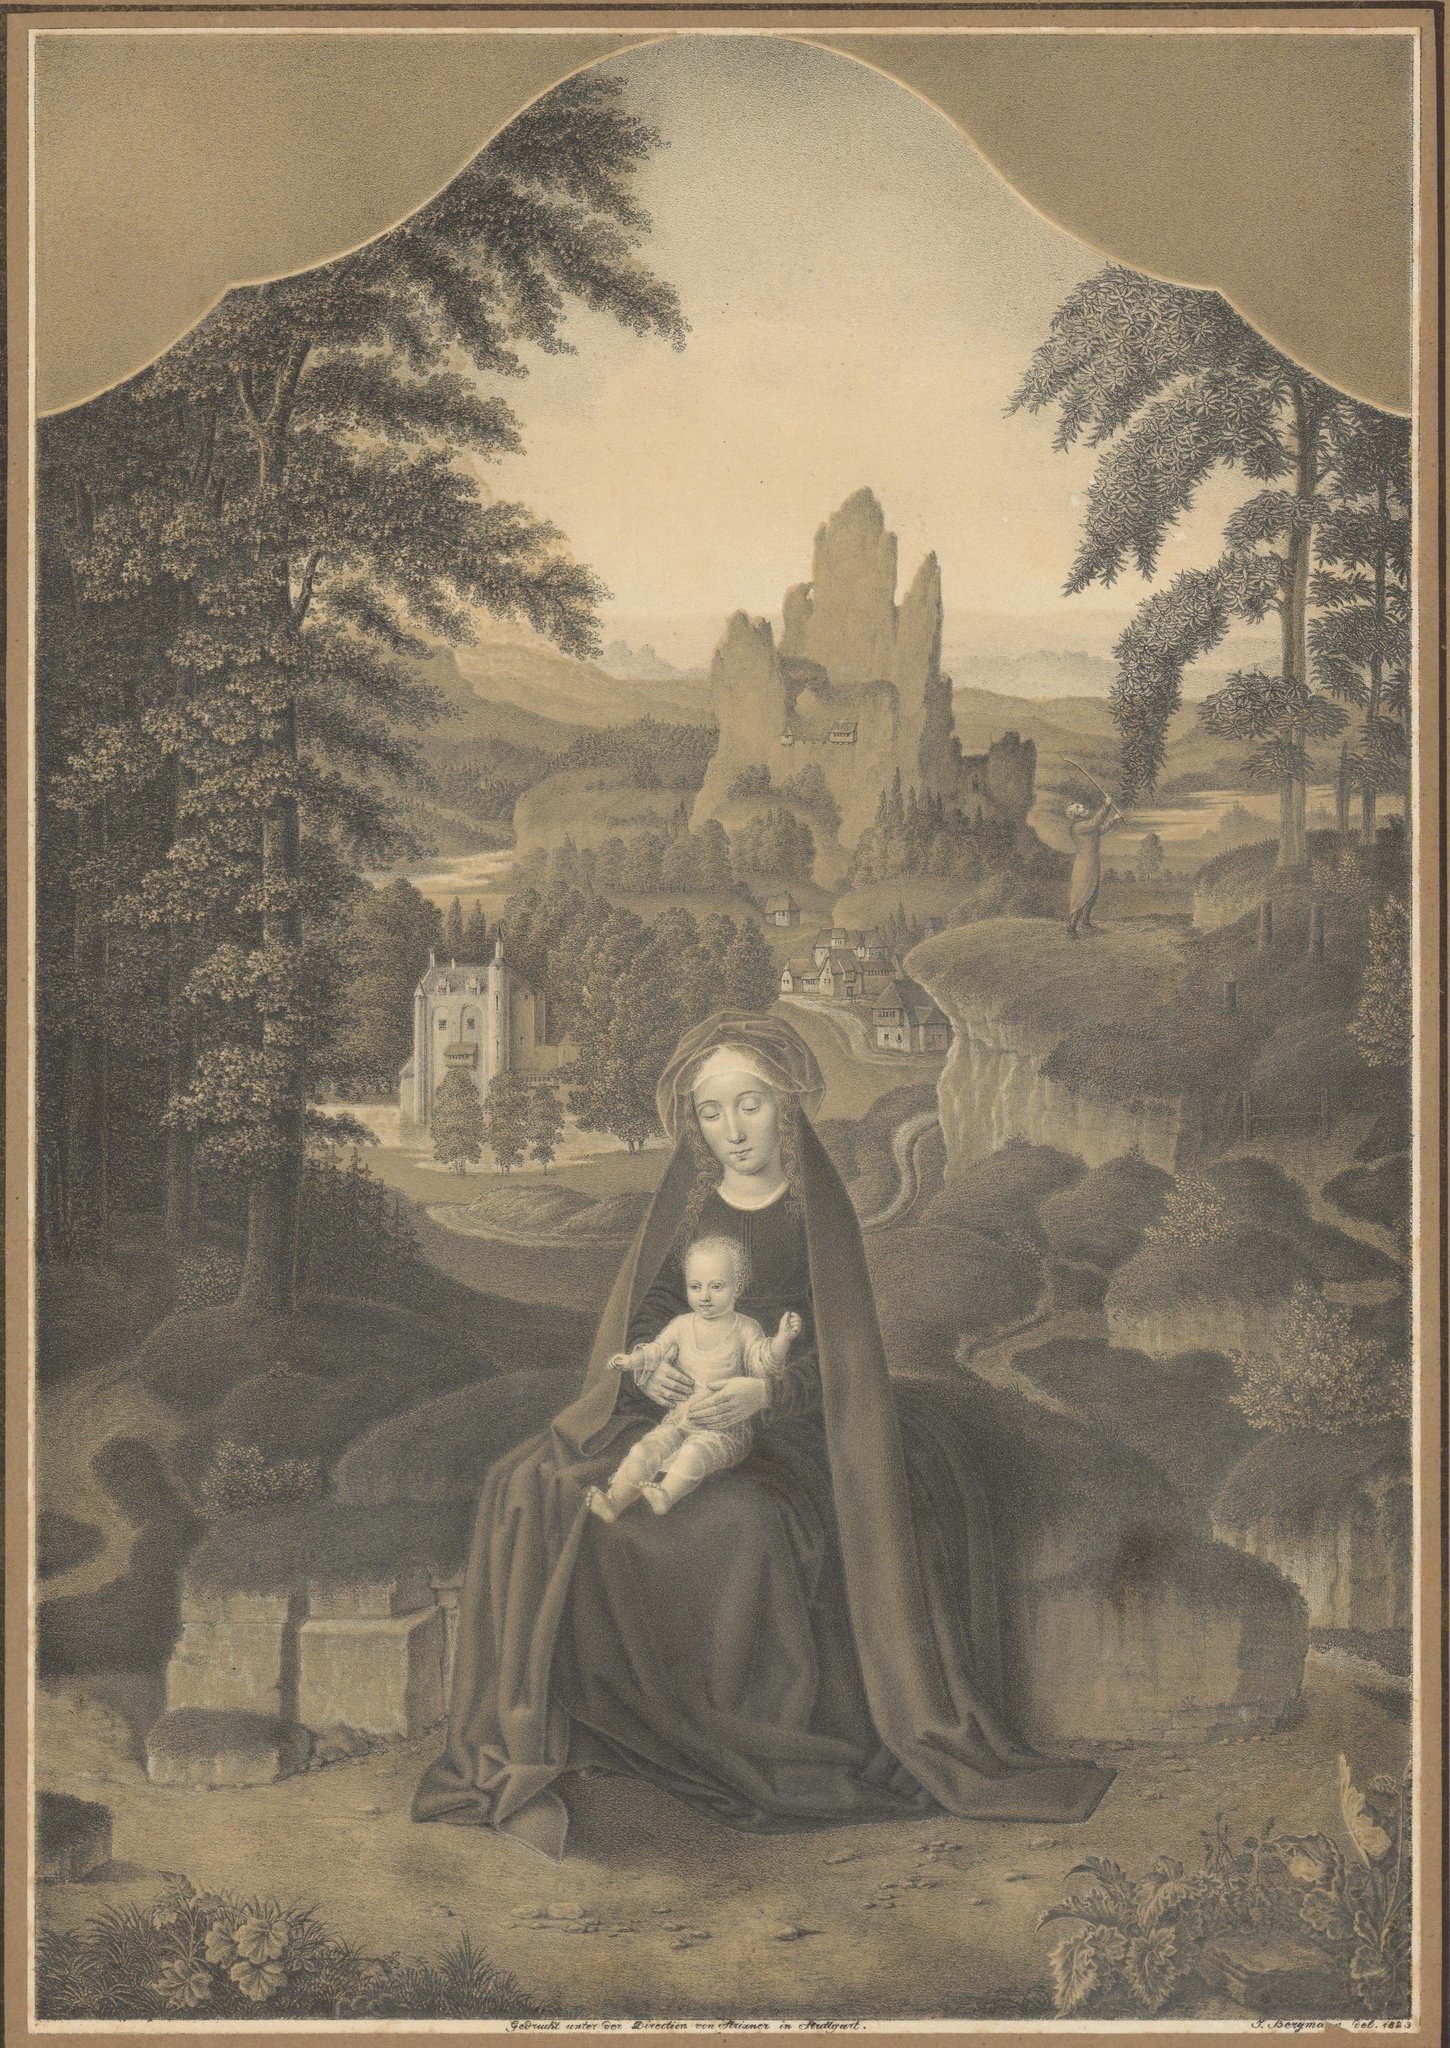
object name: print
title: Rust op de vlucht naar Egypte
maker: johann nepomuk strixner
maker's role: draughtsman, print maker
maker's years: 1782-1855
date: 1823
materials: paper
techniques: tone lithography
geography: stuttgart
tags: madonna: i.e. mary with the christ-child, rest on the flight into egypt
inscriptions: collector's mark: Lugt 2228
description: Deze prent behoort waarschijnlijk tot de serie 'Galerie des Frères Boisserée'.